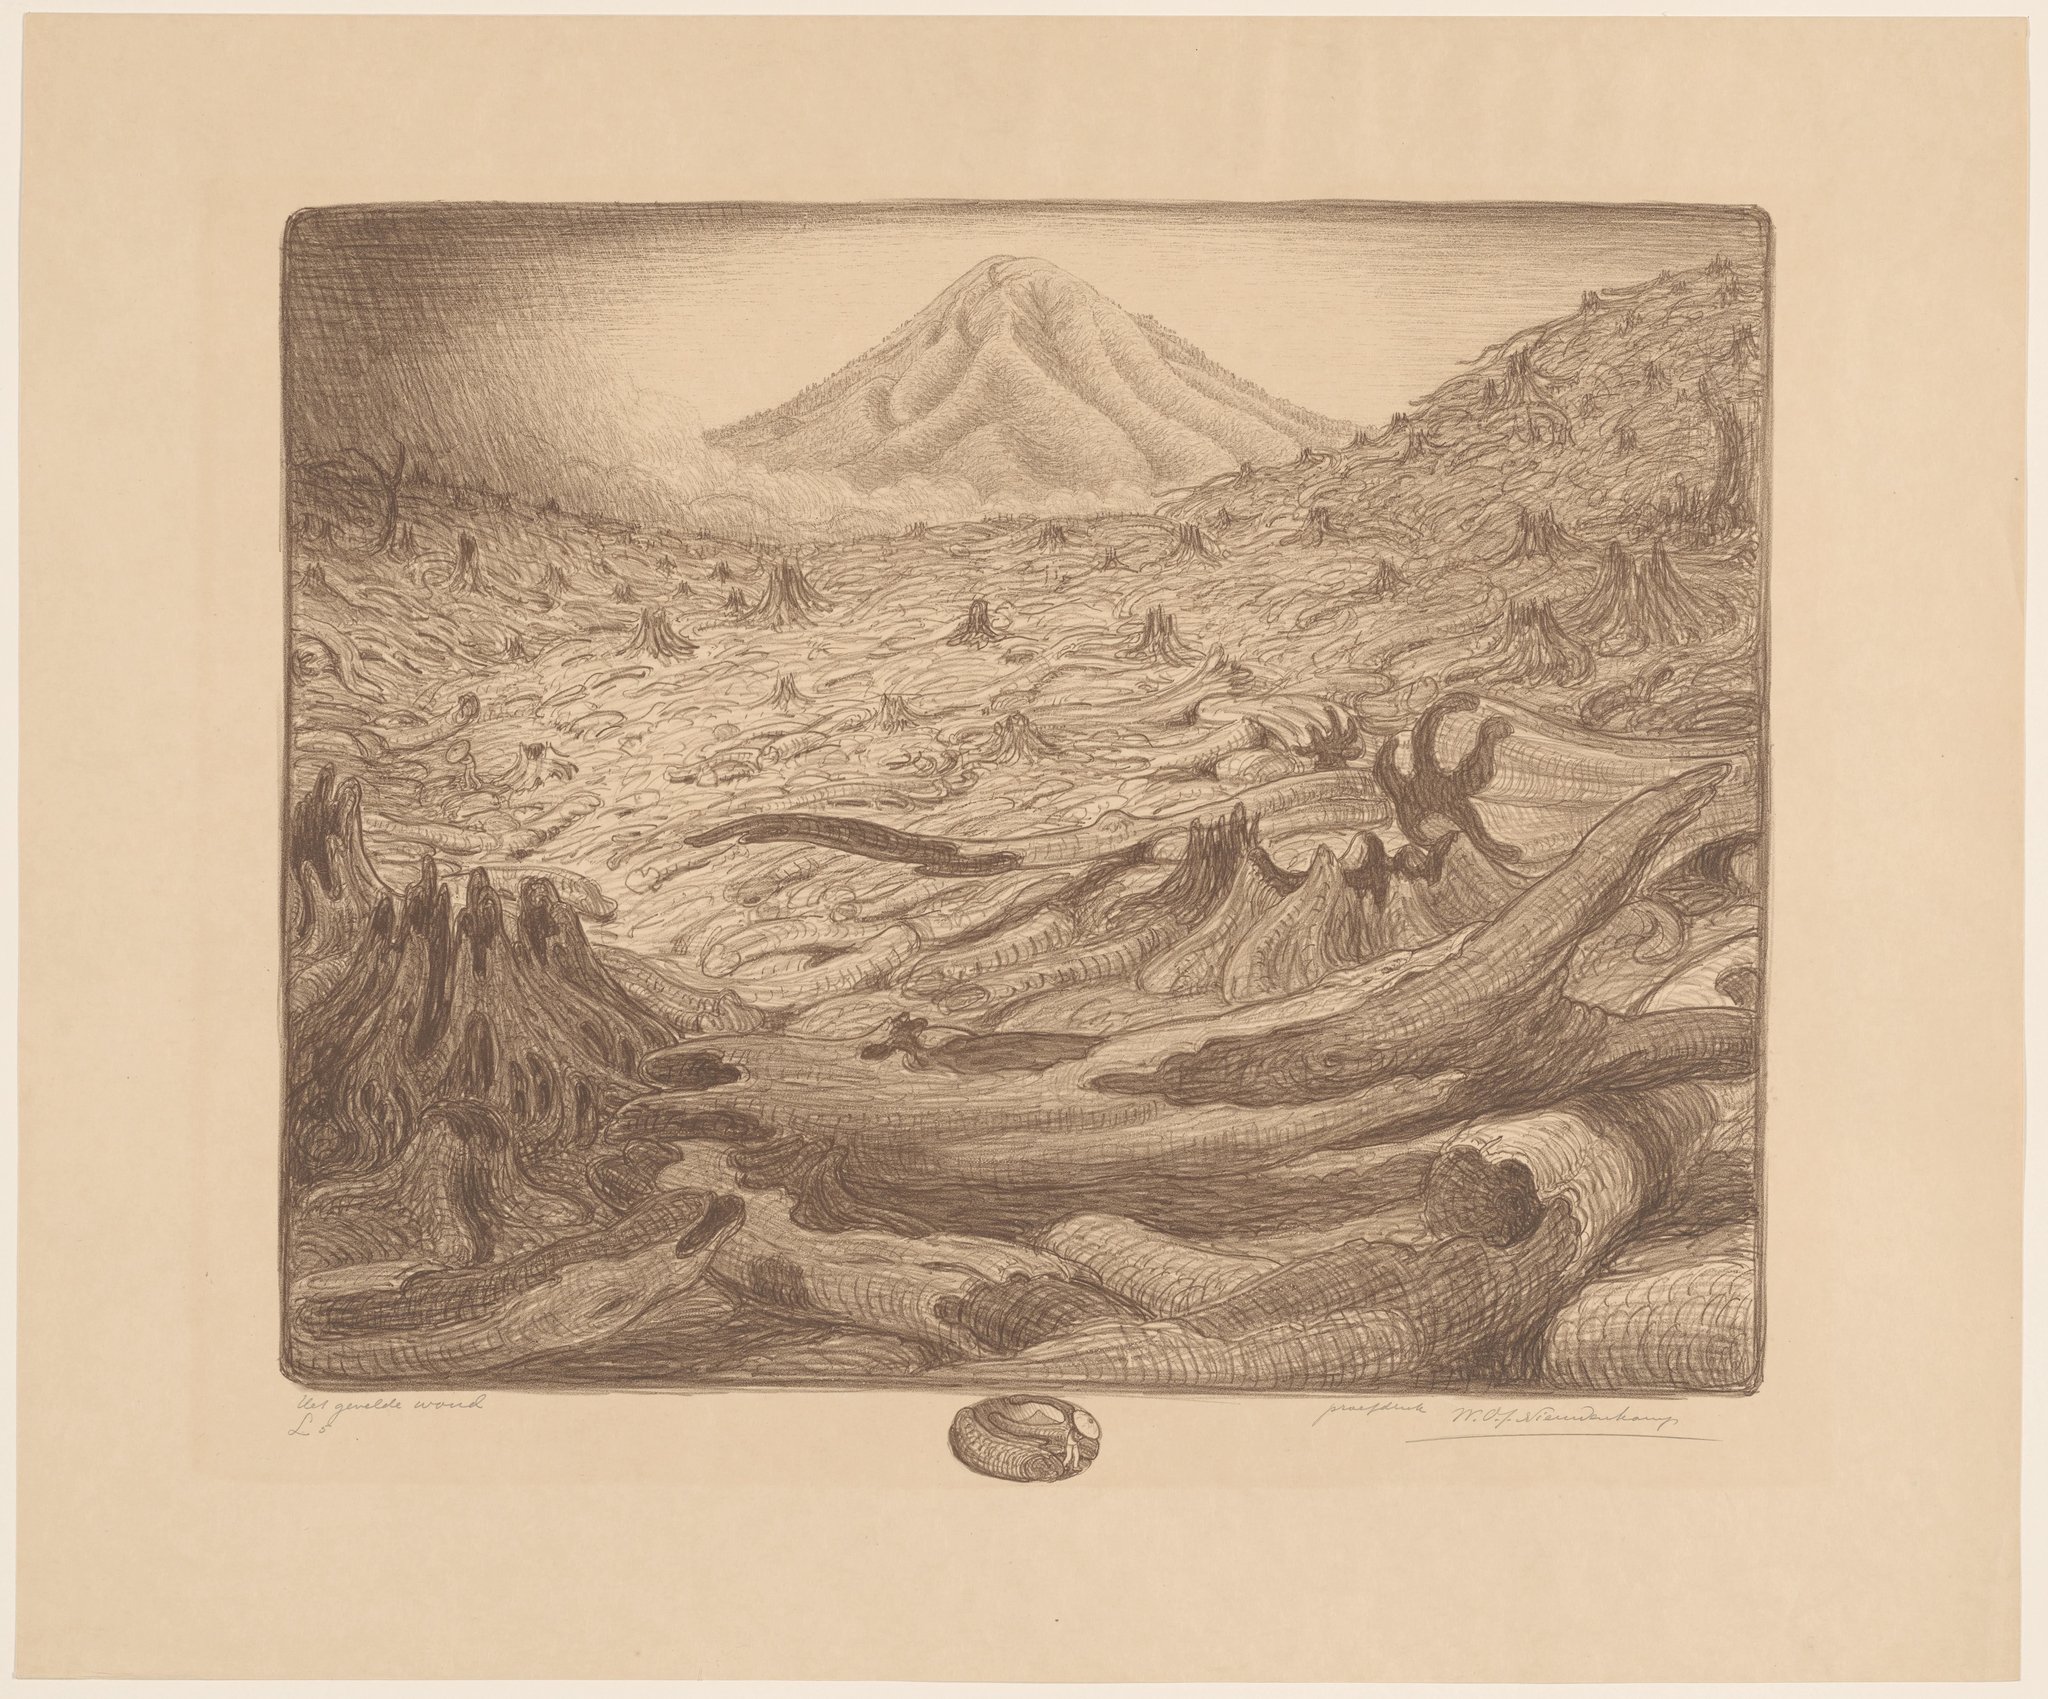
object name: print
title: Het gevelde woud. Idjèn-plateau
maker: wijnand otto jan nieuwenkamp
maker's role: draughtsman, print maker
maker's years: 1874-1950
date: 1902-1918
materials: paper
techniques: lithograph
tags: trees, forest, wood, volcano, mountains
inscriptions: collector's mark: Lugt 2233